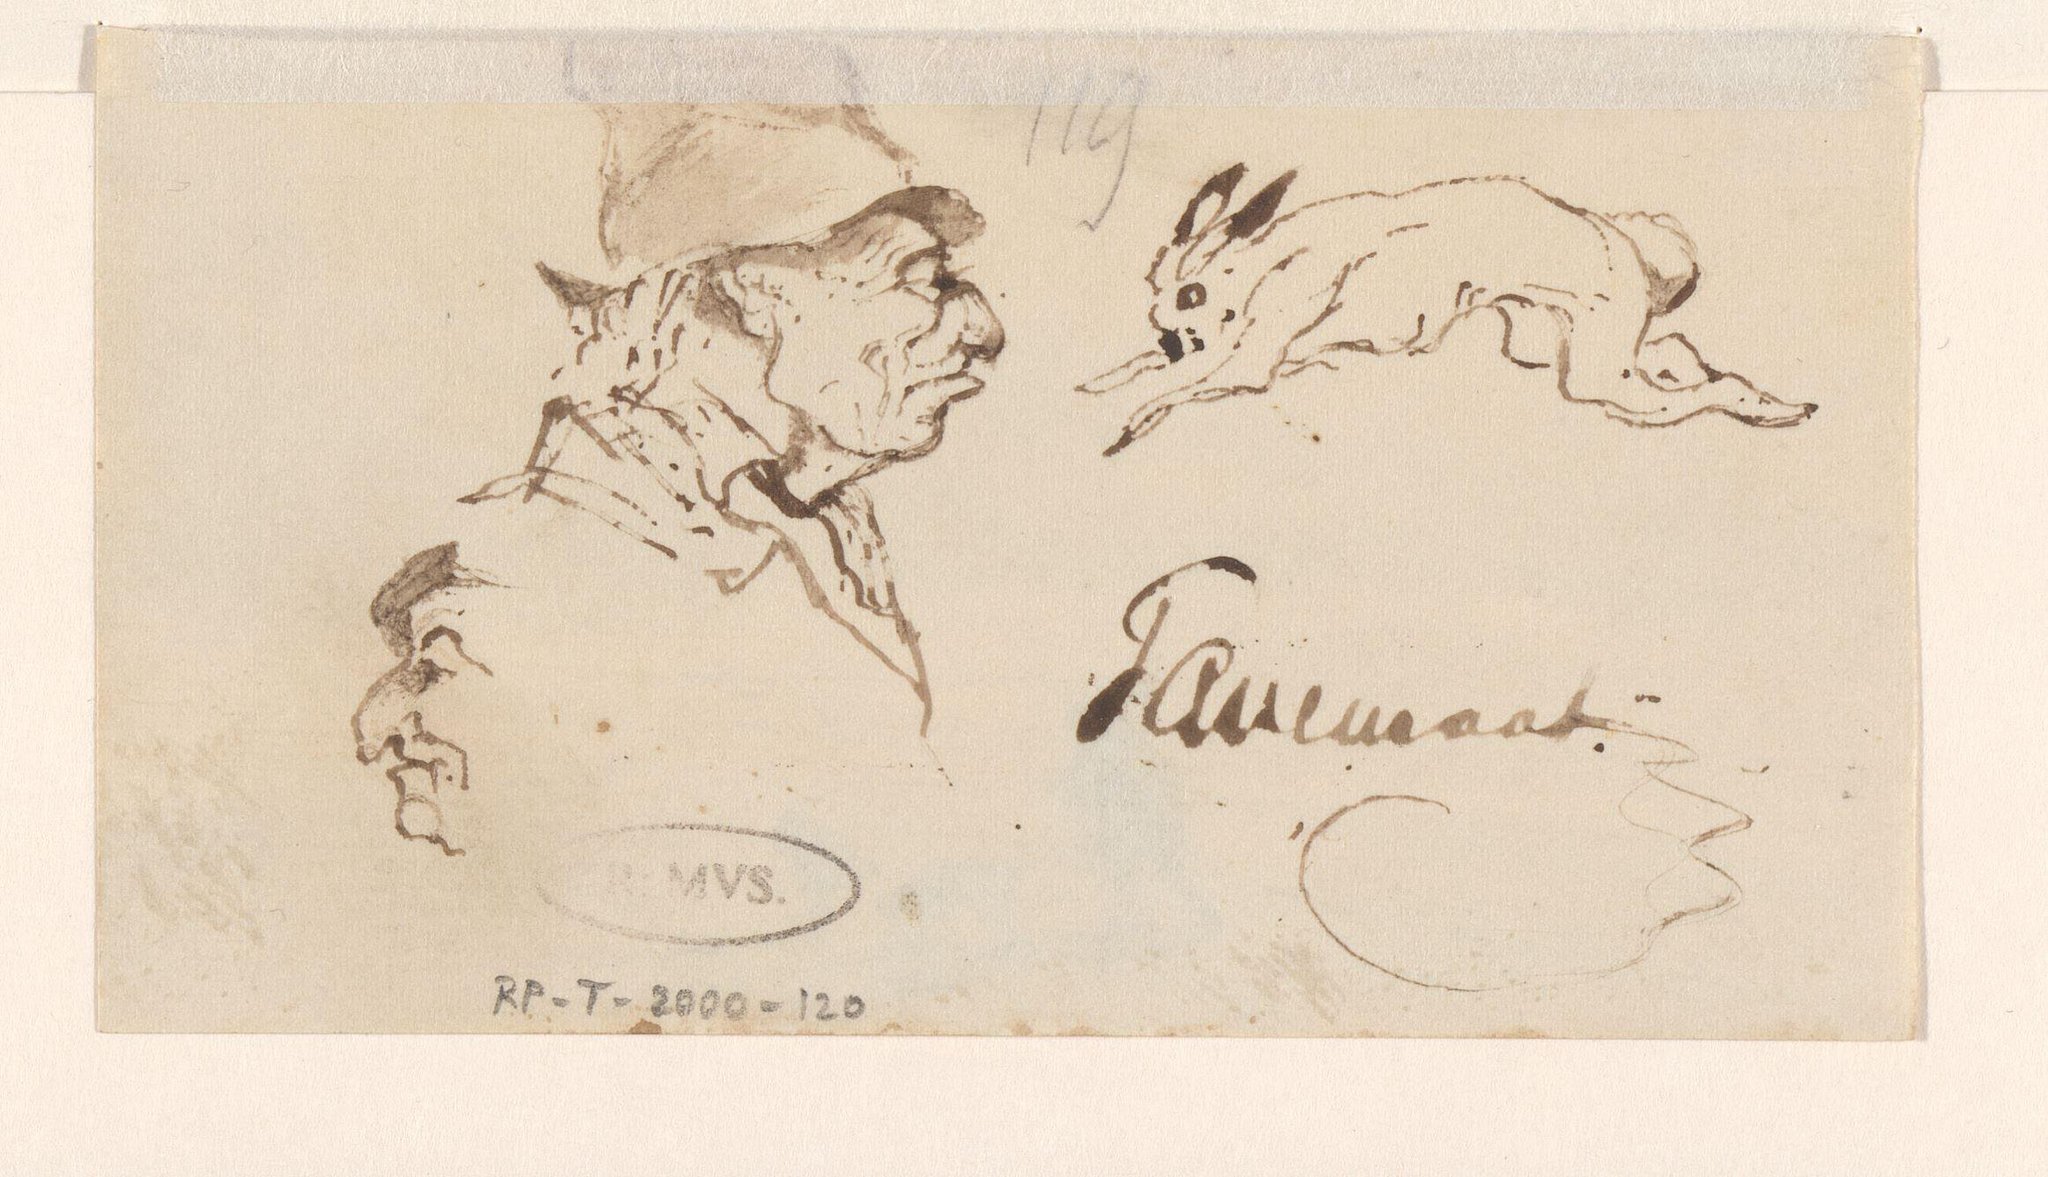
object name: drawing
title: Haas en twee koppen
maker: johannes tavenraat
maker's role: draughtsman, painter, print maker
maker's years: 1809-1881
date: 1840-1870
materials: ink, paper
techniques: brush, pen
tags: hunter, hare-hunting, rabbit-hunting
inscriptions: signature: ‘Tavenraat’, collector's mark: Lugt 2228